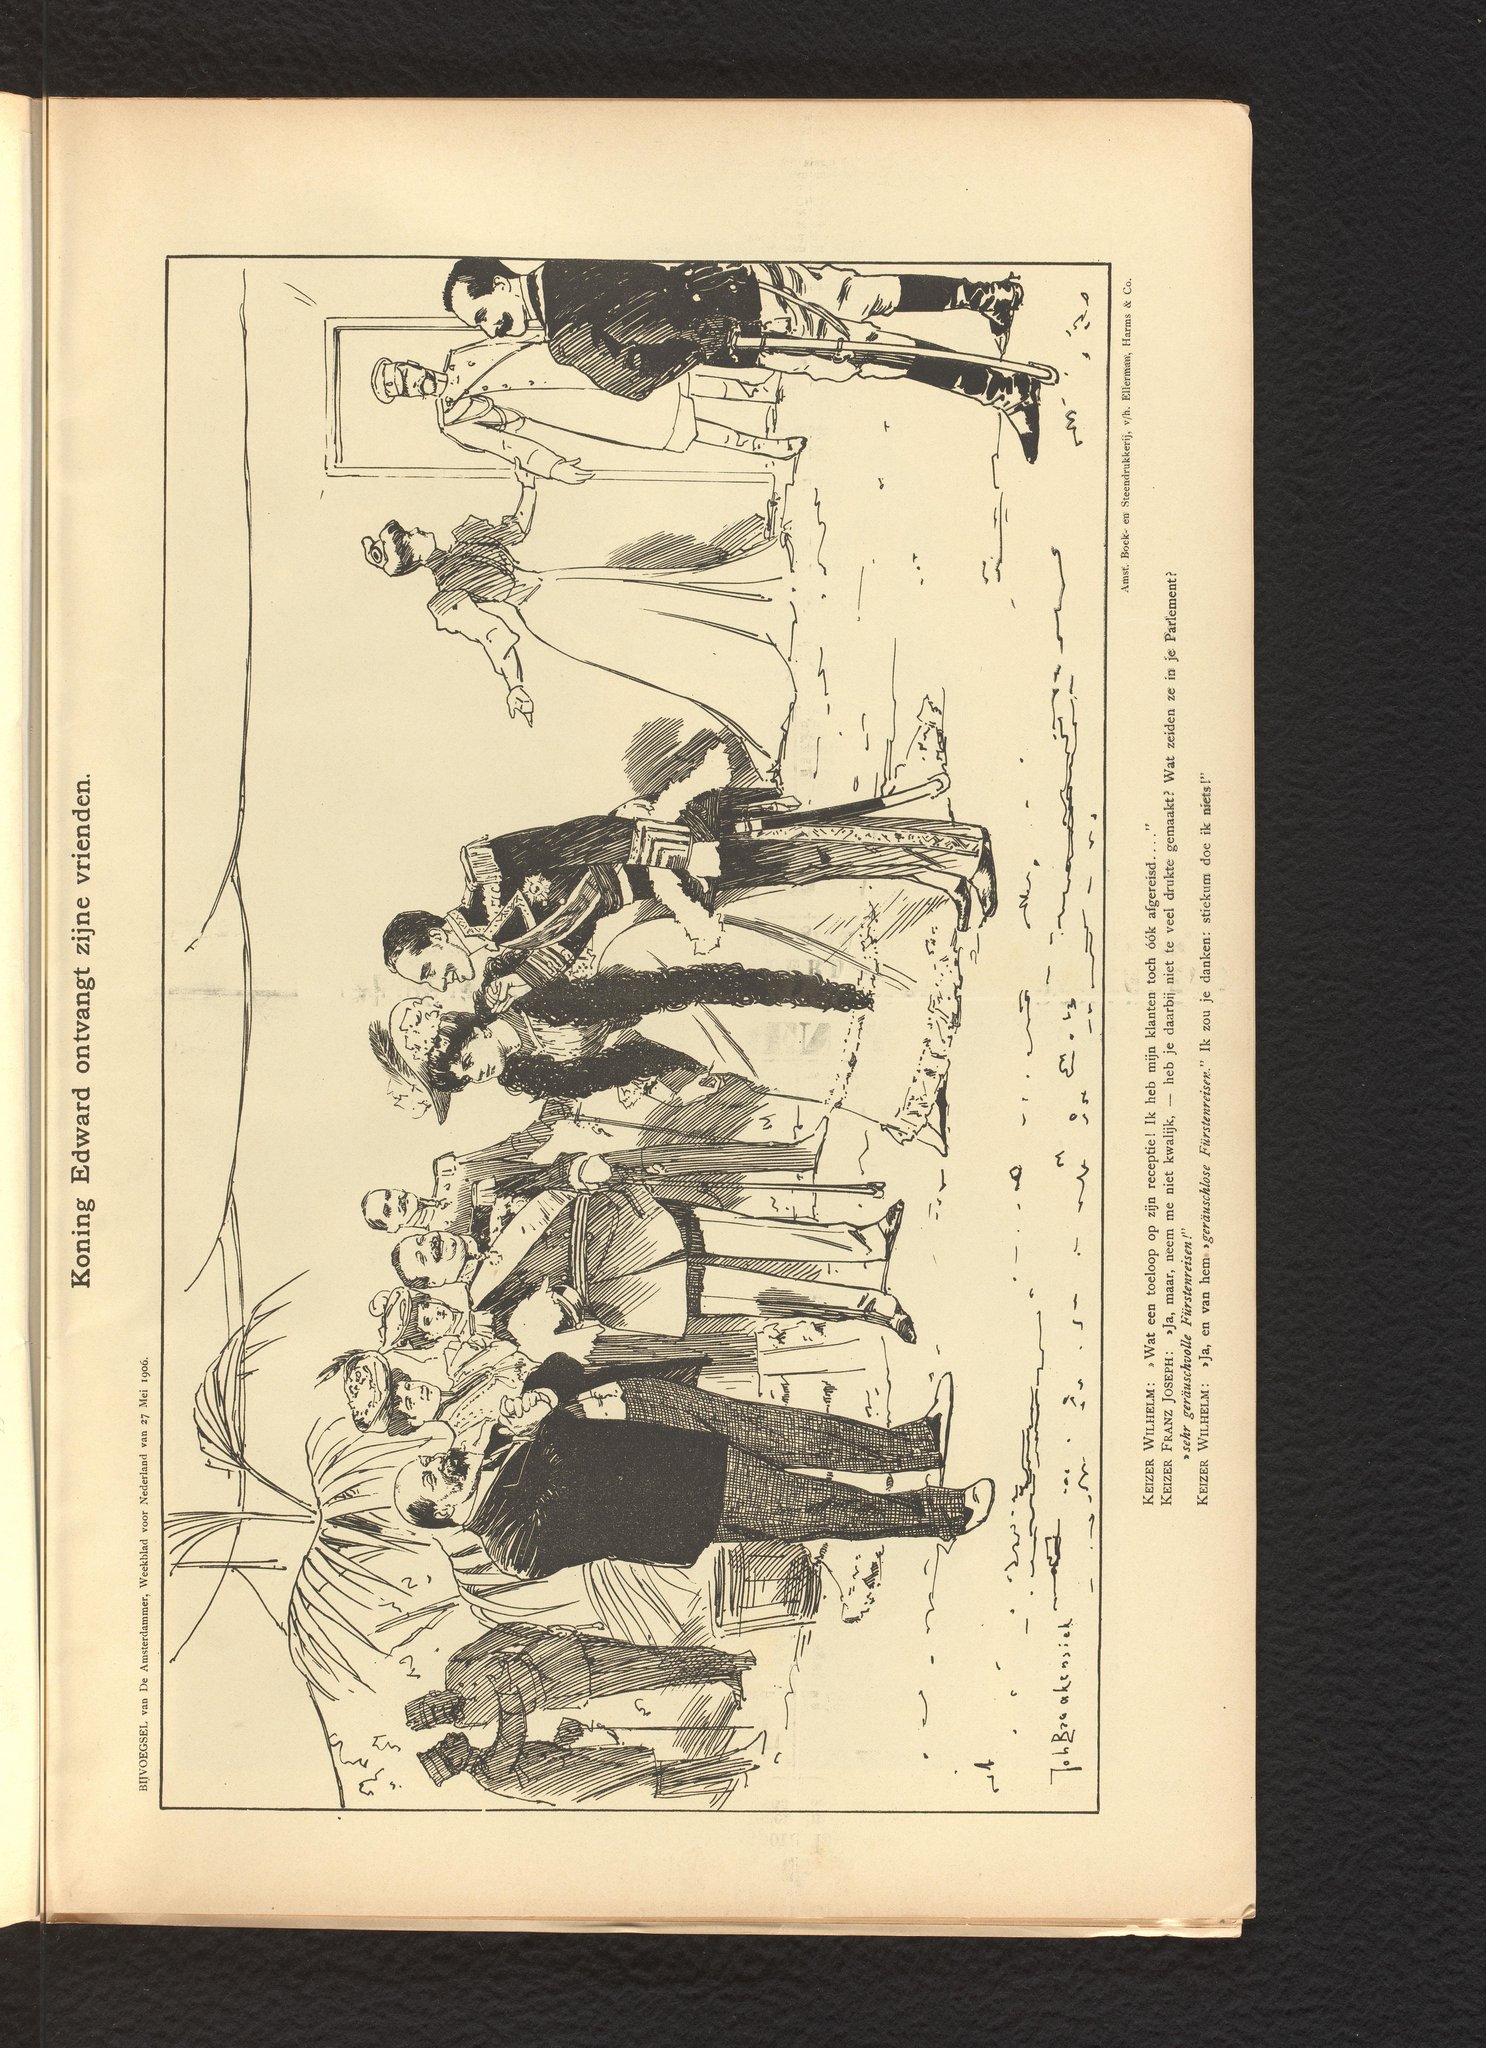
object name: cartoon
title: Koning Edward ontvangt zijne vrienden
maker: johan braakensiek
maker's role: draughtsman, print maker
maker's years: 1858-1940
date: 1906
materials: paper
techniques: lithograph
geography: amsterdam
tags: vienna, wilhelm ii (keizer van duitsland), personifications of countries, nations, states, districts, etc., reception, cocktail party, political caricatures and satires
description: De Engelse koning Edward VII ontvangt op een receptie buitenlandse vorsten, links achter de planten smoezen de Duitse keizer Wilhelm II en de Oostenrijkse keizer Frans Jozef I met elkaar. Rechts probeert Marianne (Frankrijk) de Russische tsaar Nicolaas II te overreden om op de receptie te blijven.